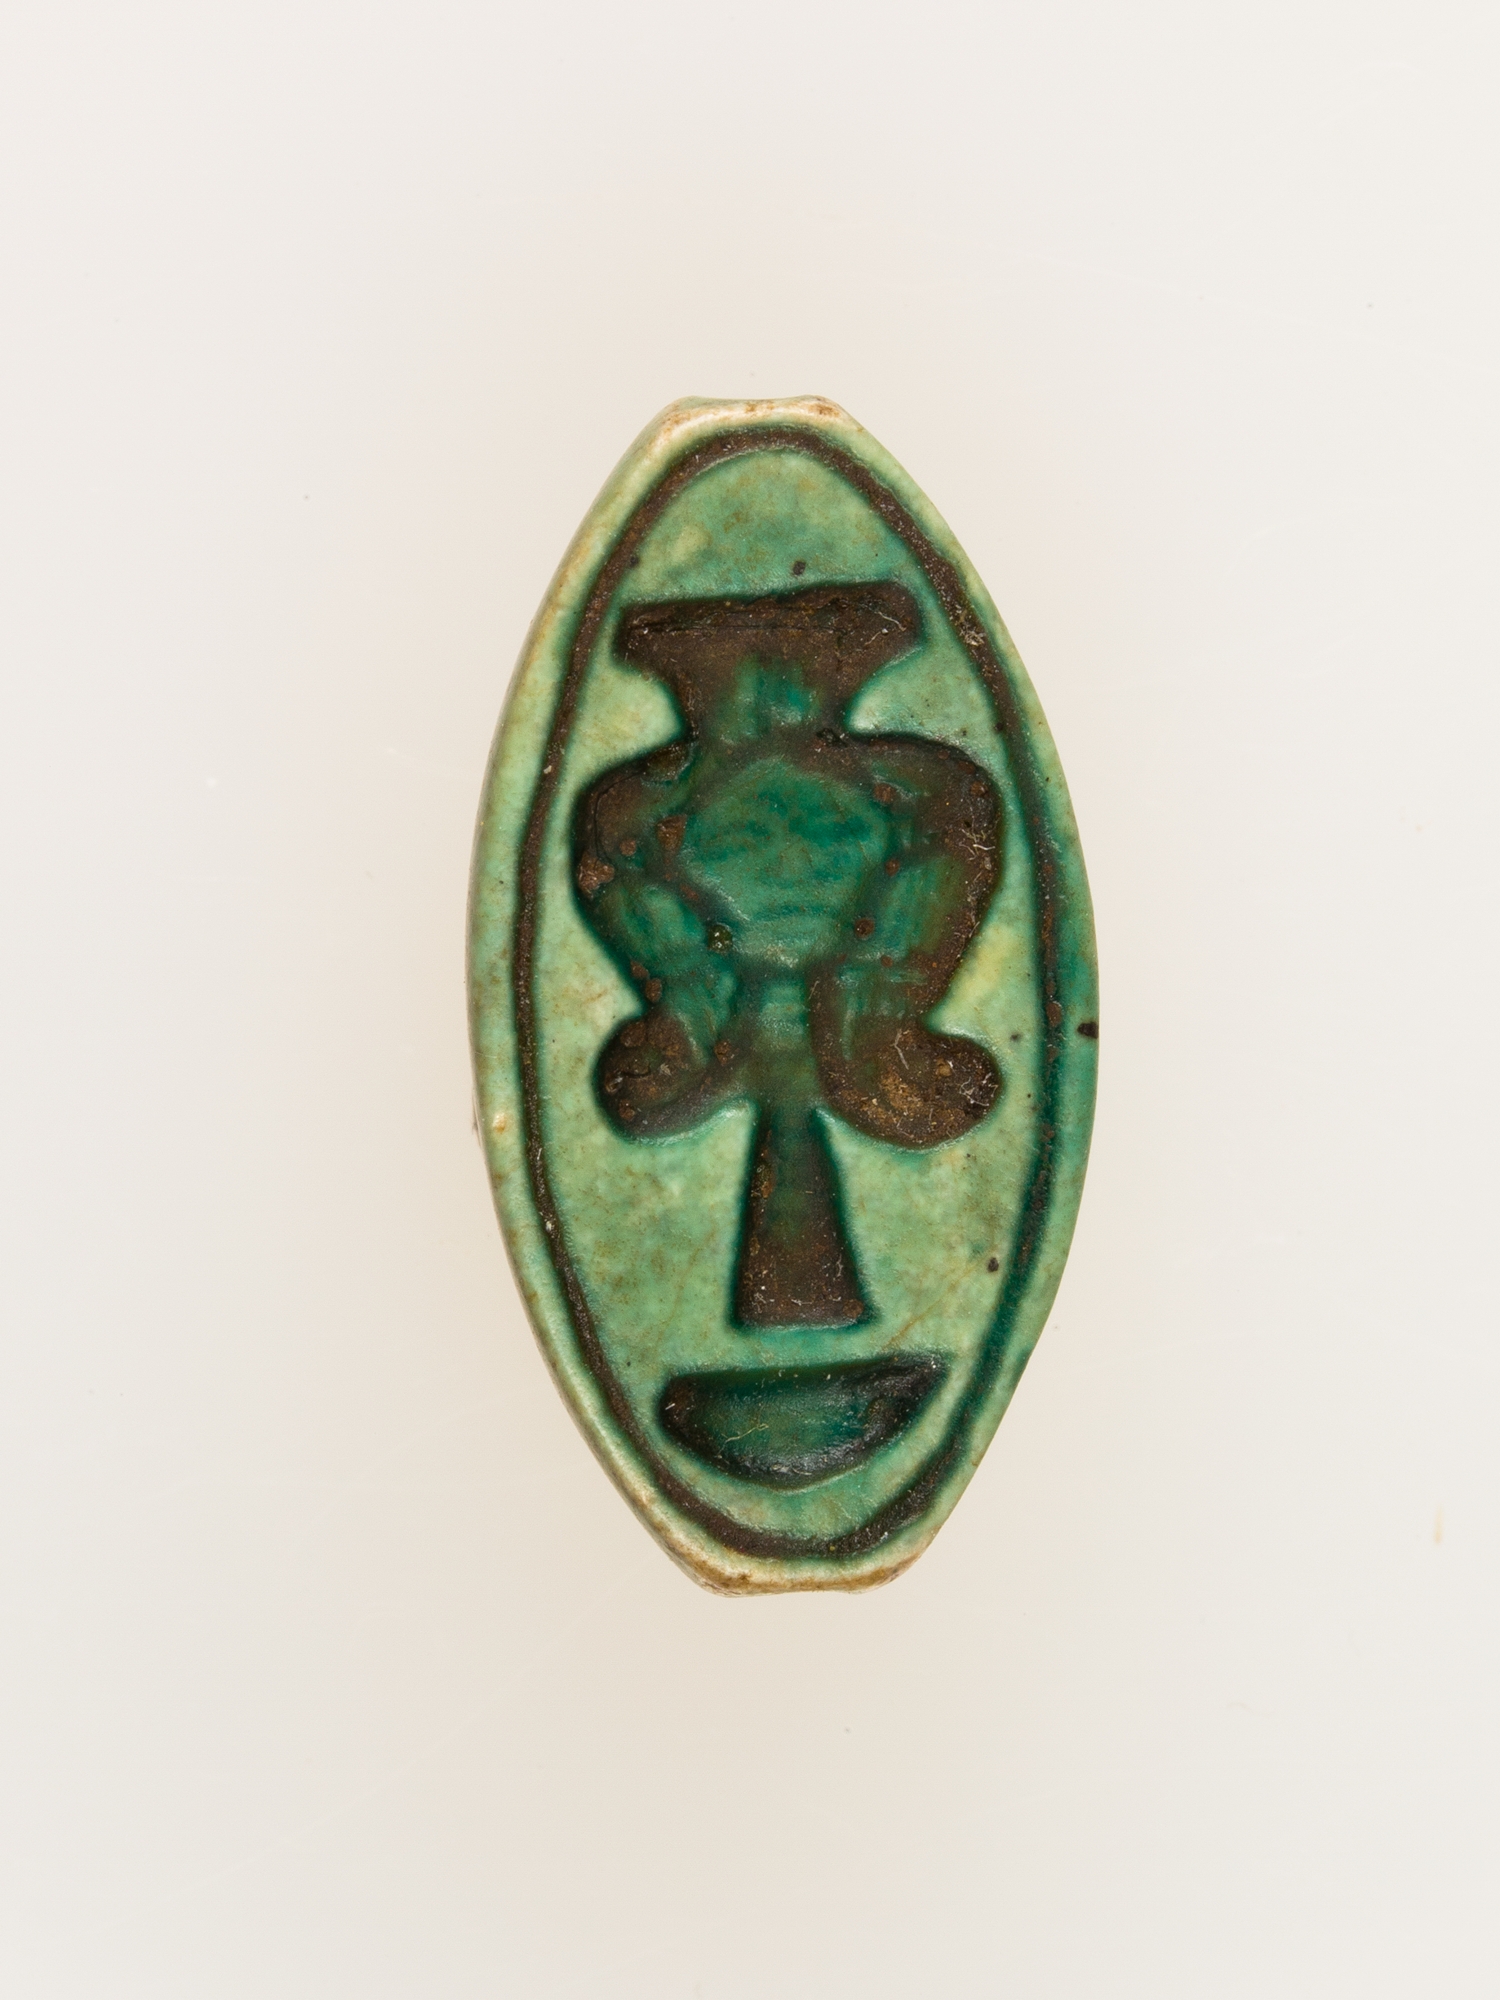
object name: cowroid with hathor emblem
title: Cowroid with a Hathor emblem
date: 1550-1295 BCE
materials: faience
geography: egypt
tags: hathor